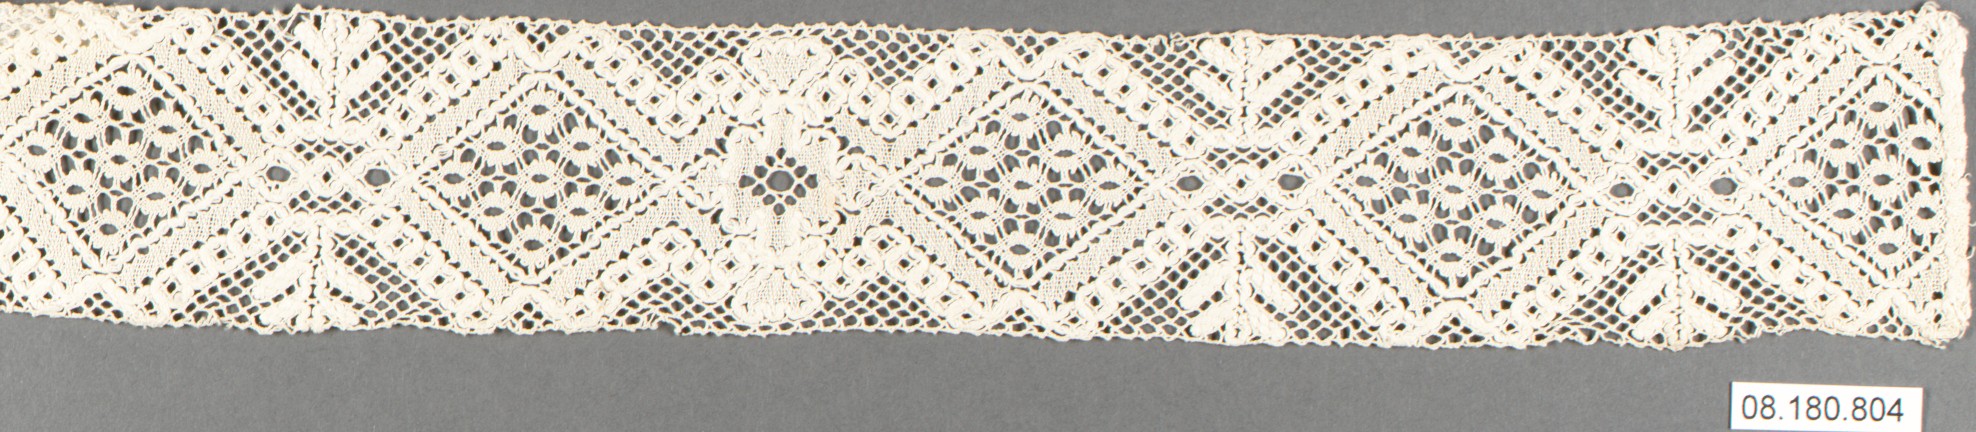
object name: fragment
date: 1801-1900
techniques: lace